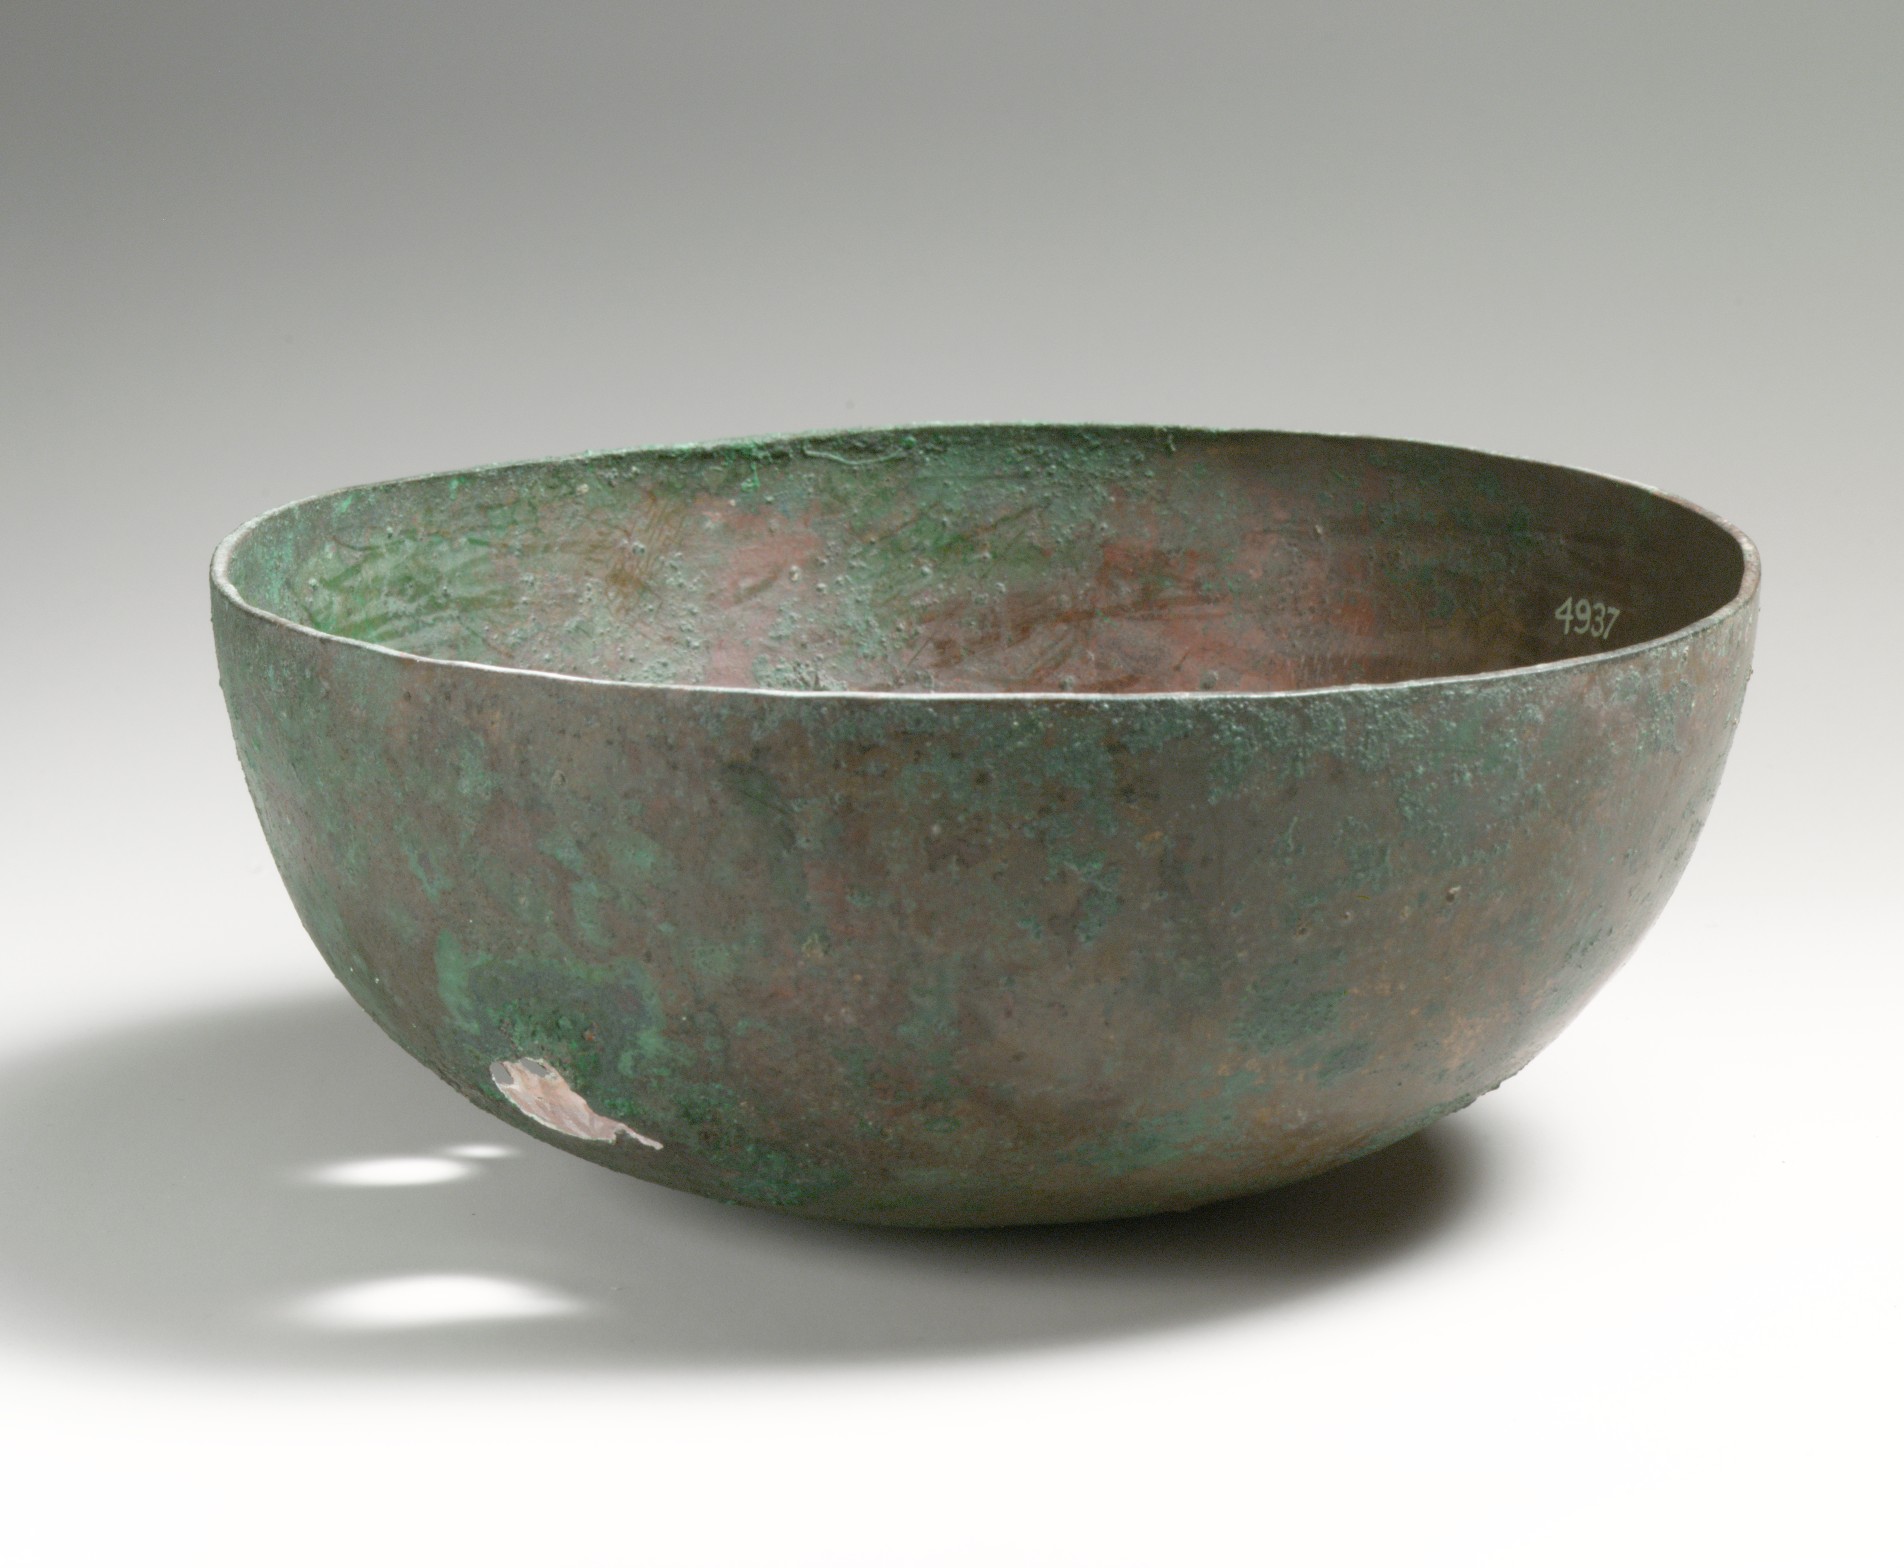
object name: bowl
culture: cypriot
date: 3900 BCE-100 CE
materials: bronze